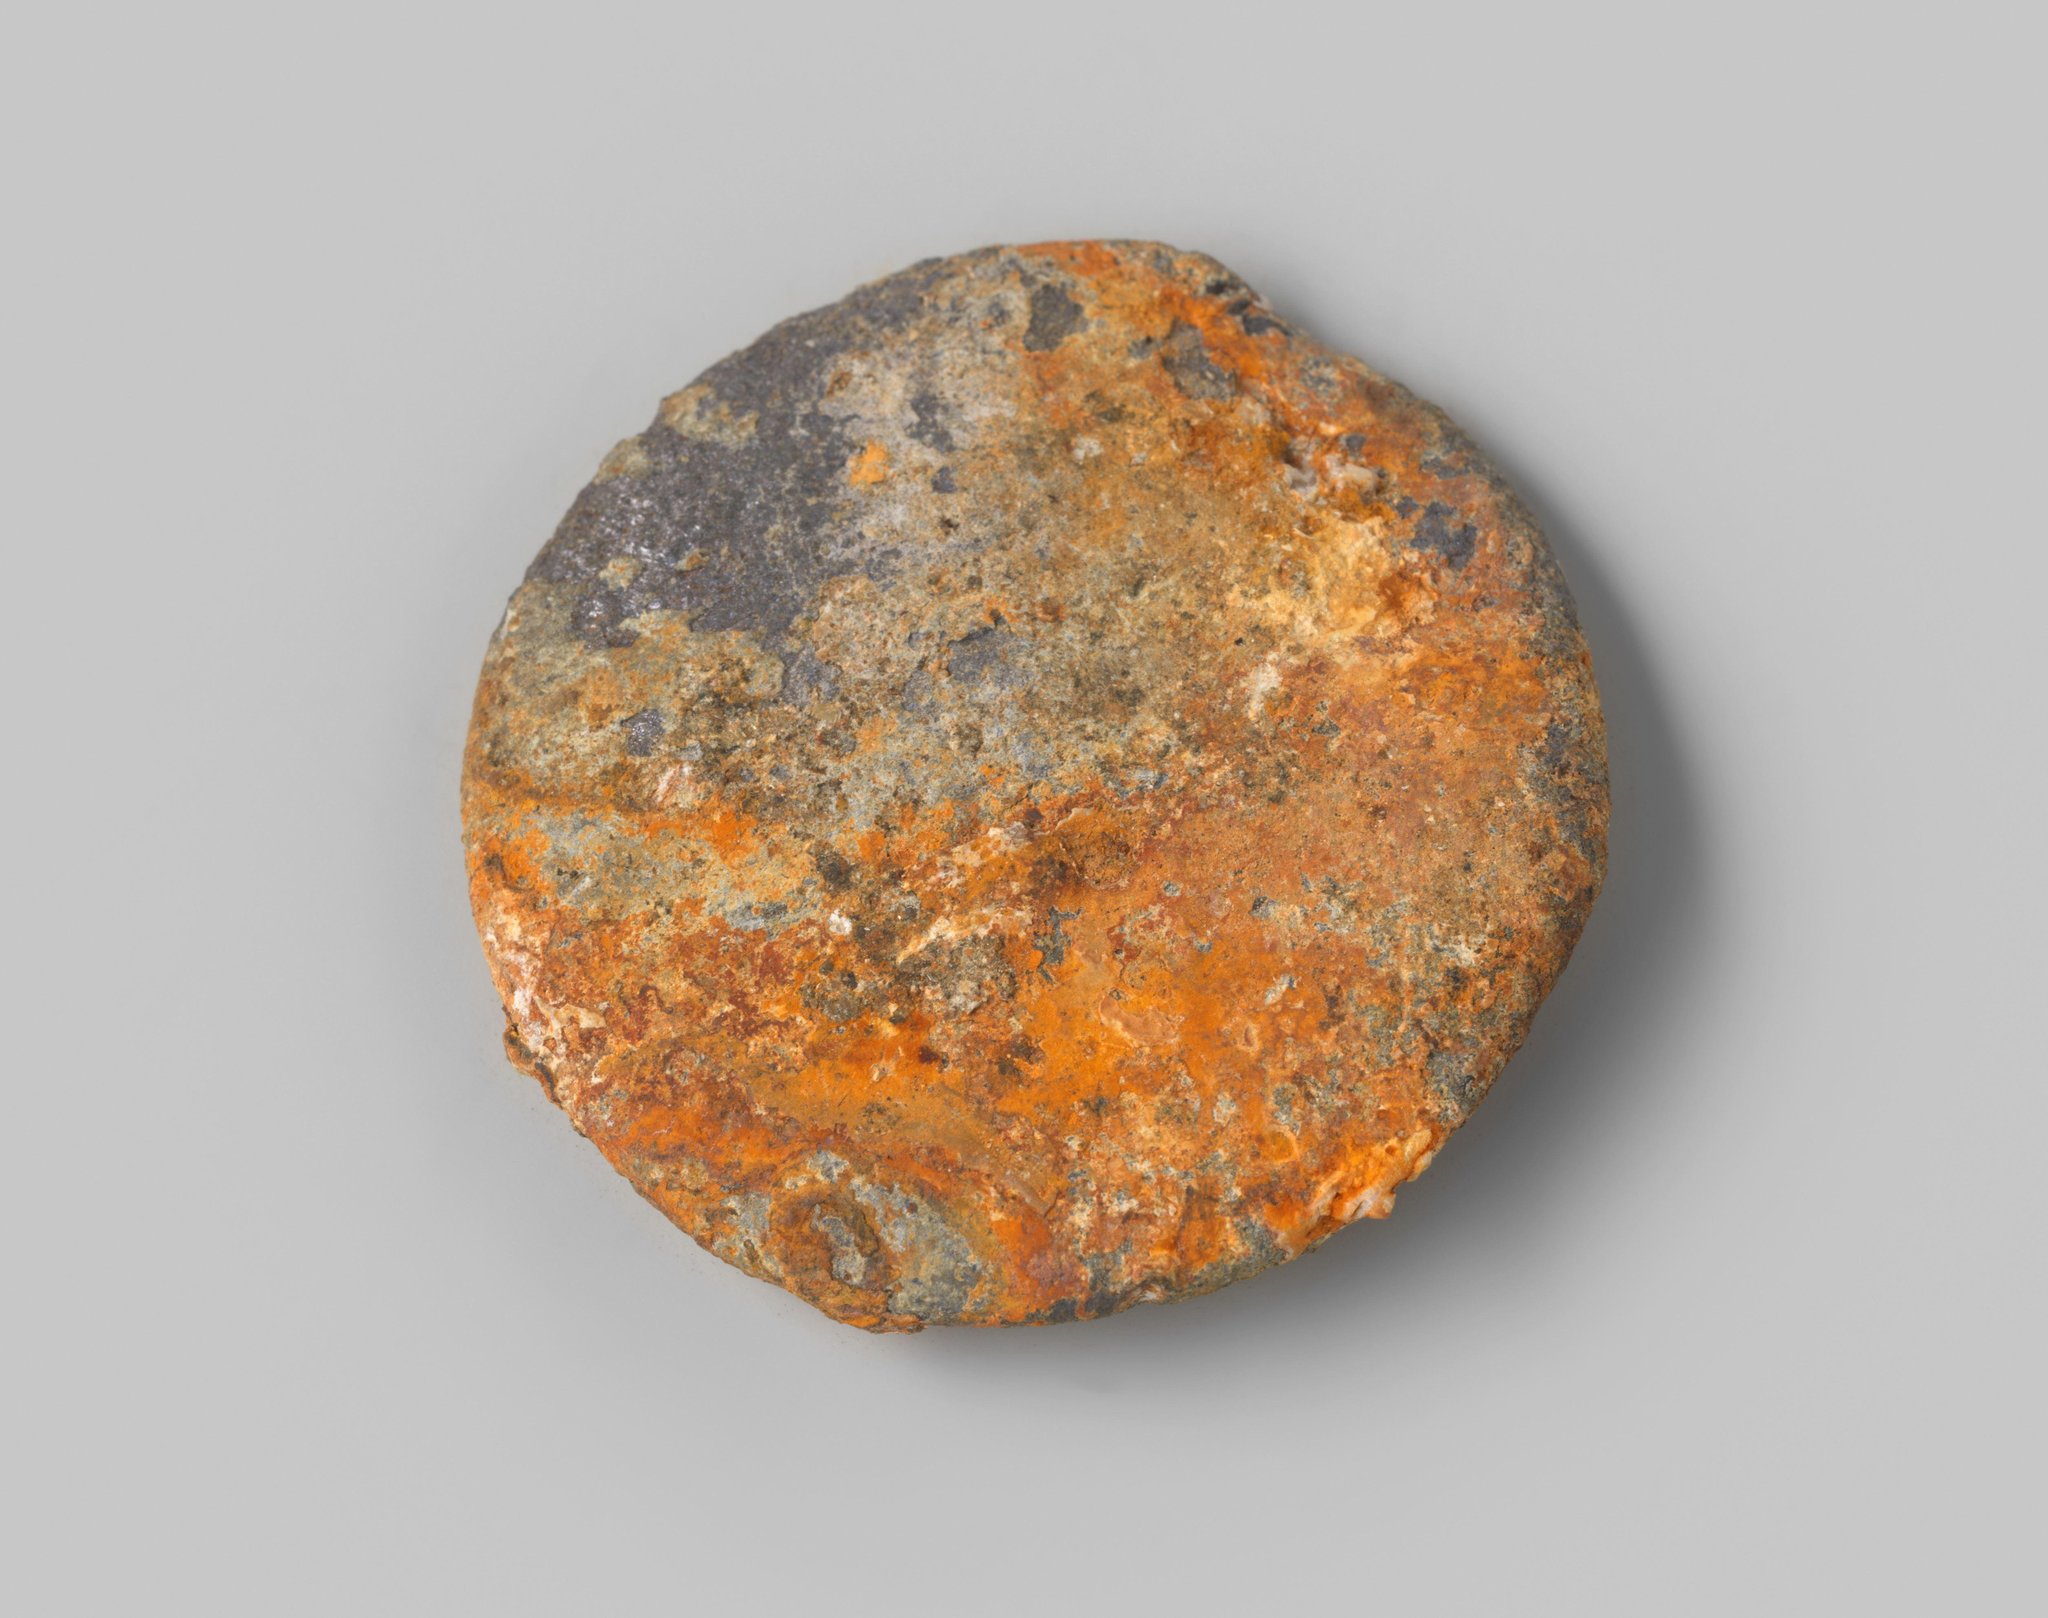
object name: weight scale component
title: Gewicht uit het wrak van de Oost-Indiëvaarder Hollandia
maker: Anonymous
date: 1700-1743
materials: lead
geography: netherlands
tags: verenigde oostindische compagnie, hollandia (schip), annet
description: Disc-shaped weight, sim. NG 1980-27H851, corroded.